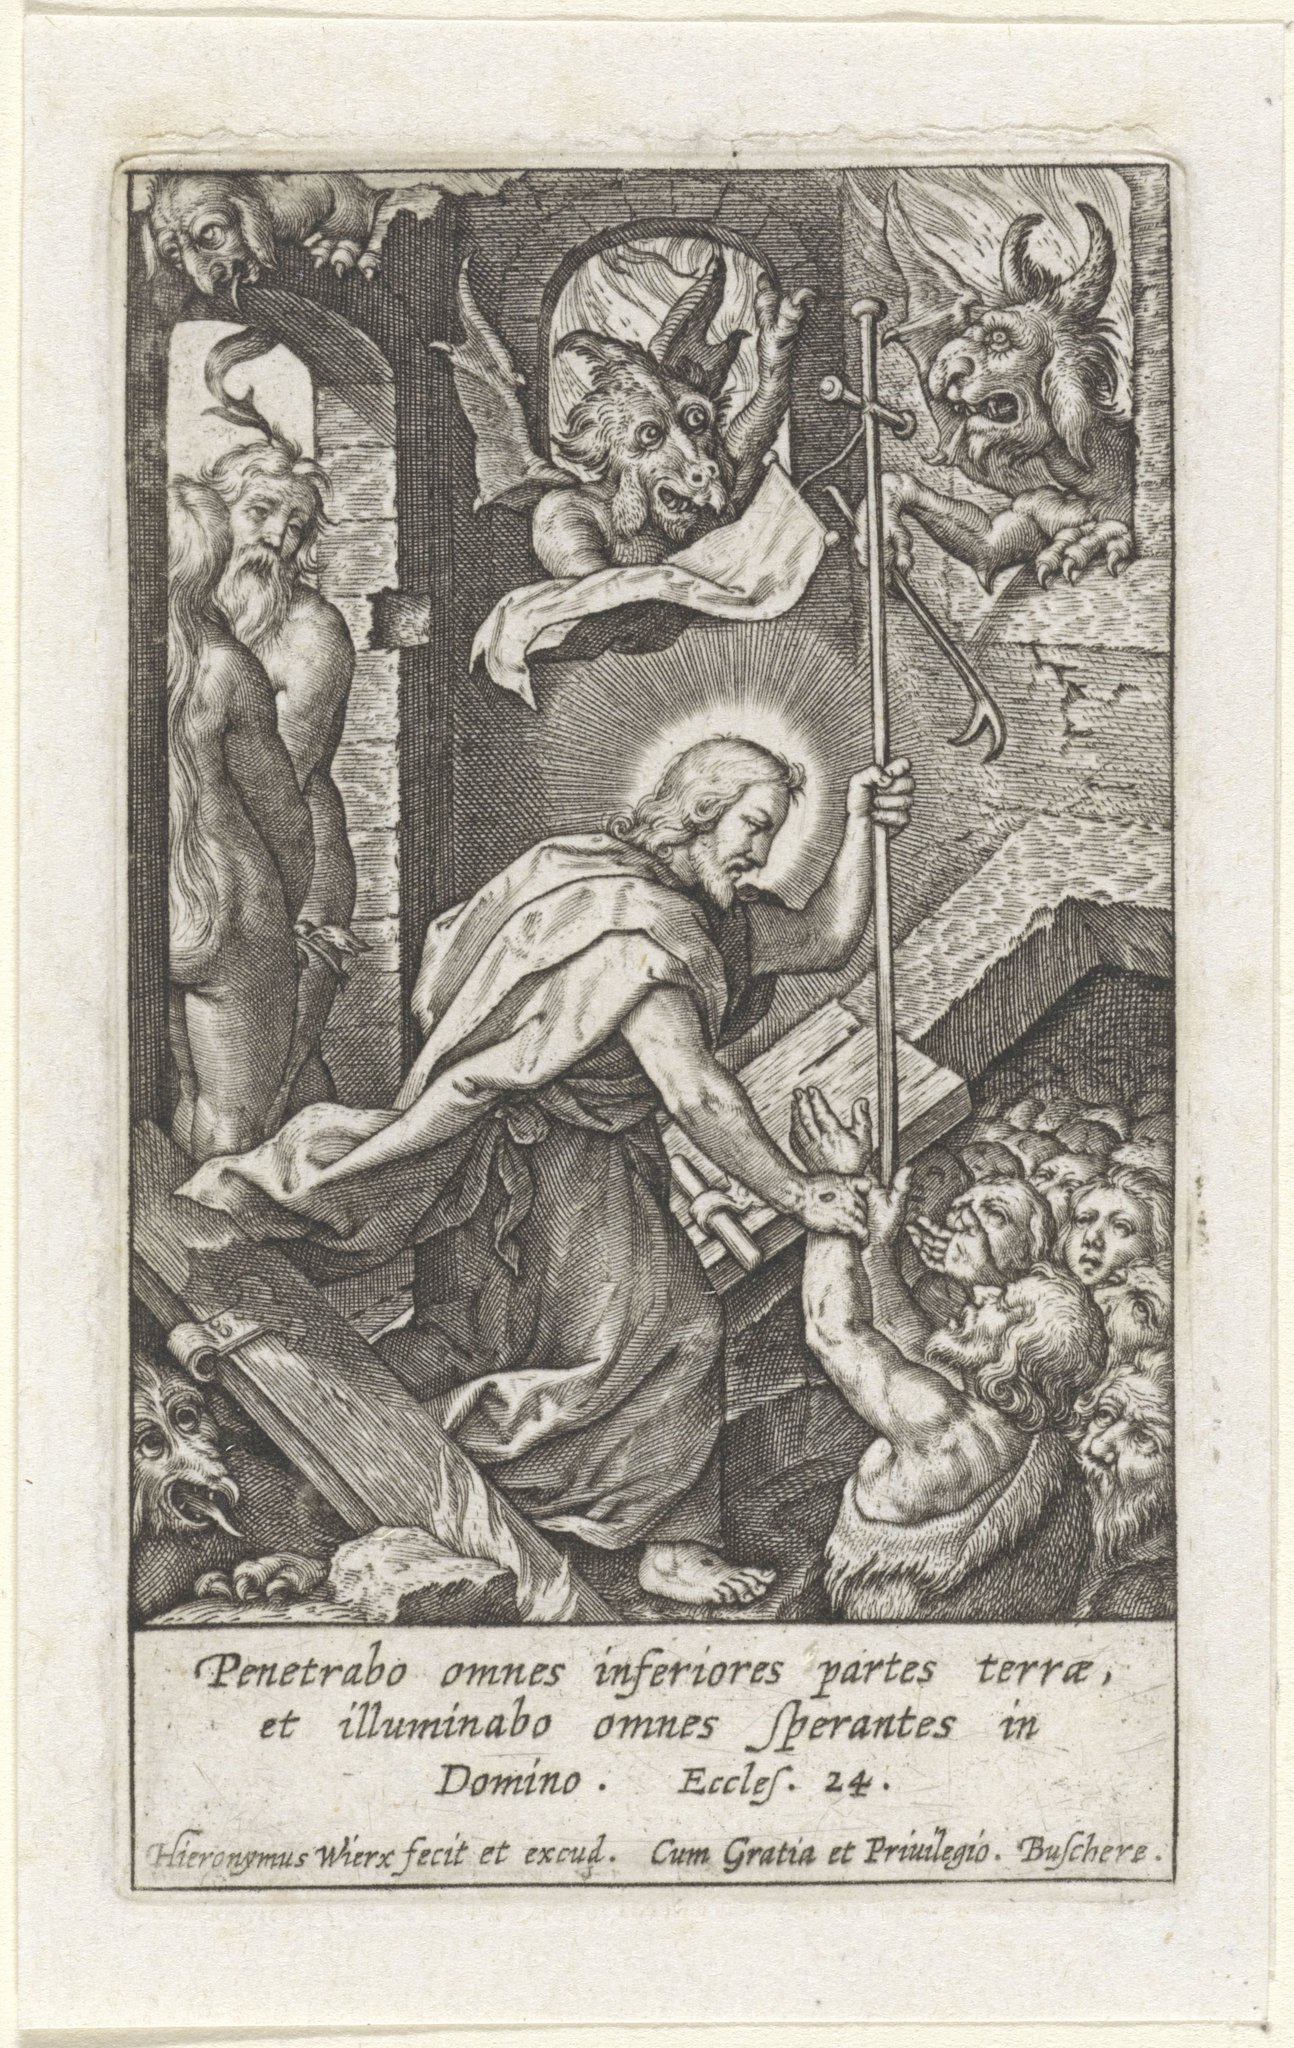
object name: print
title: Passio Domini Nostri Iesv Christi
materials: paper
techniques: engraving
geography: antwerp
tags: christ arrives at the entrance of hell and breaks the door(s)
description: Na zijn dood daalt Christus af in het voorgeborchte. Bij de poorten van de hel reikt hij de hand aan anonieme figuren. Aan de linkerzijde lopen een man en vrouw weg. Duivels kijken toe. In de marge een drieregelig Bijbelcitaat uit Sir. 24 in het Latijn.